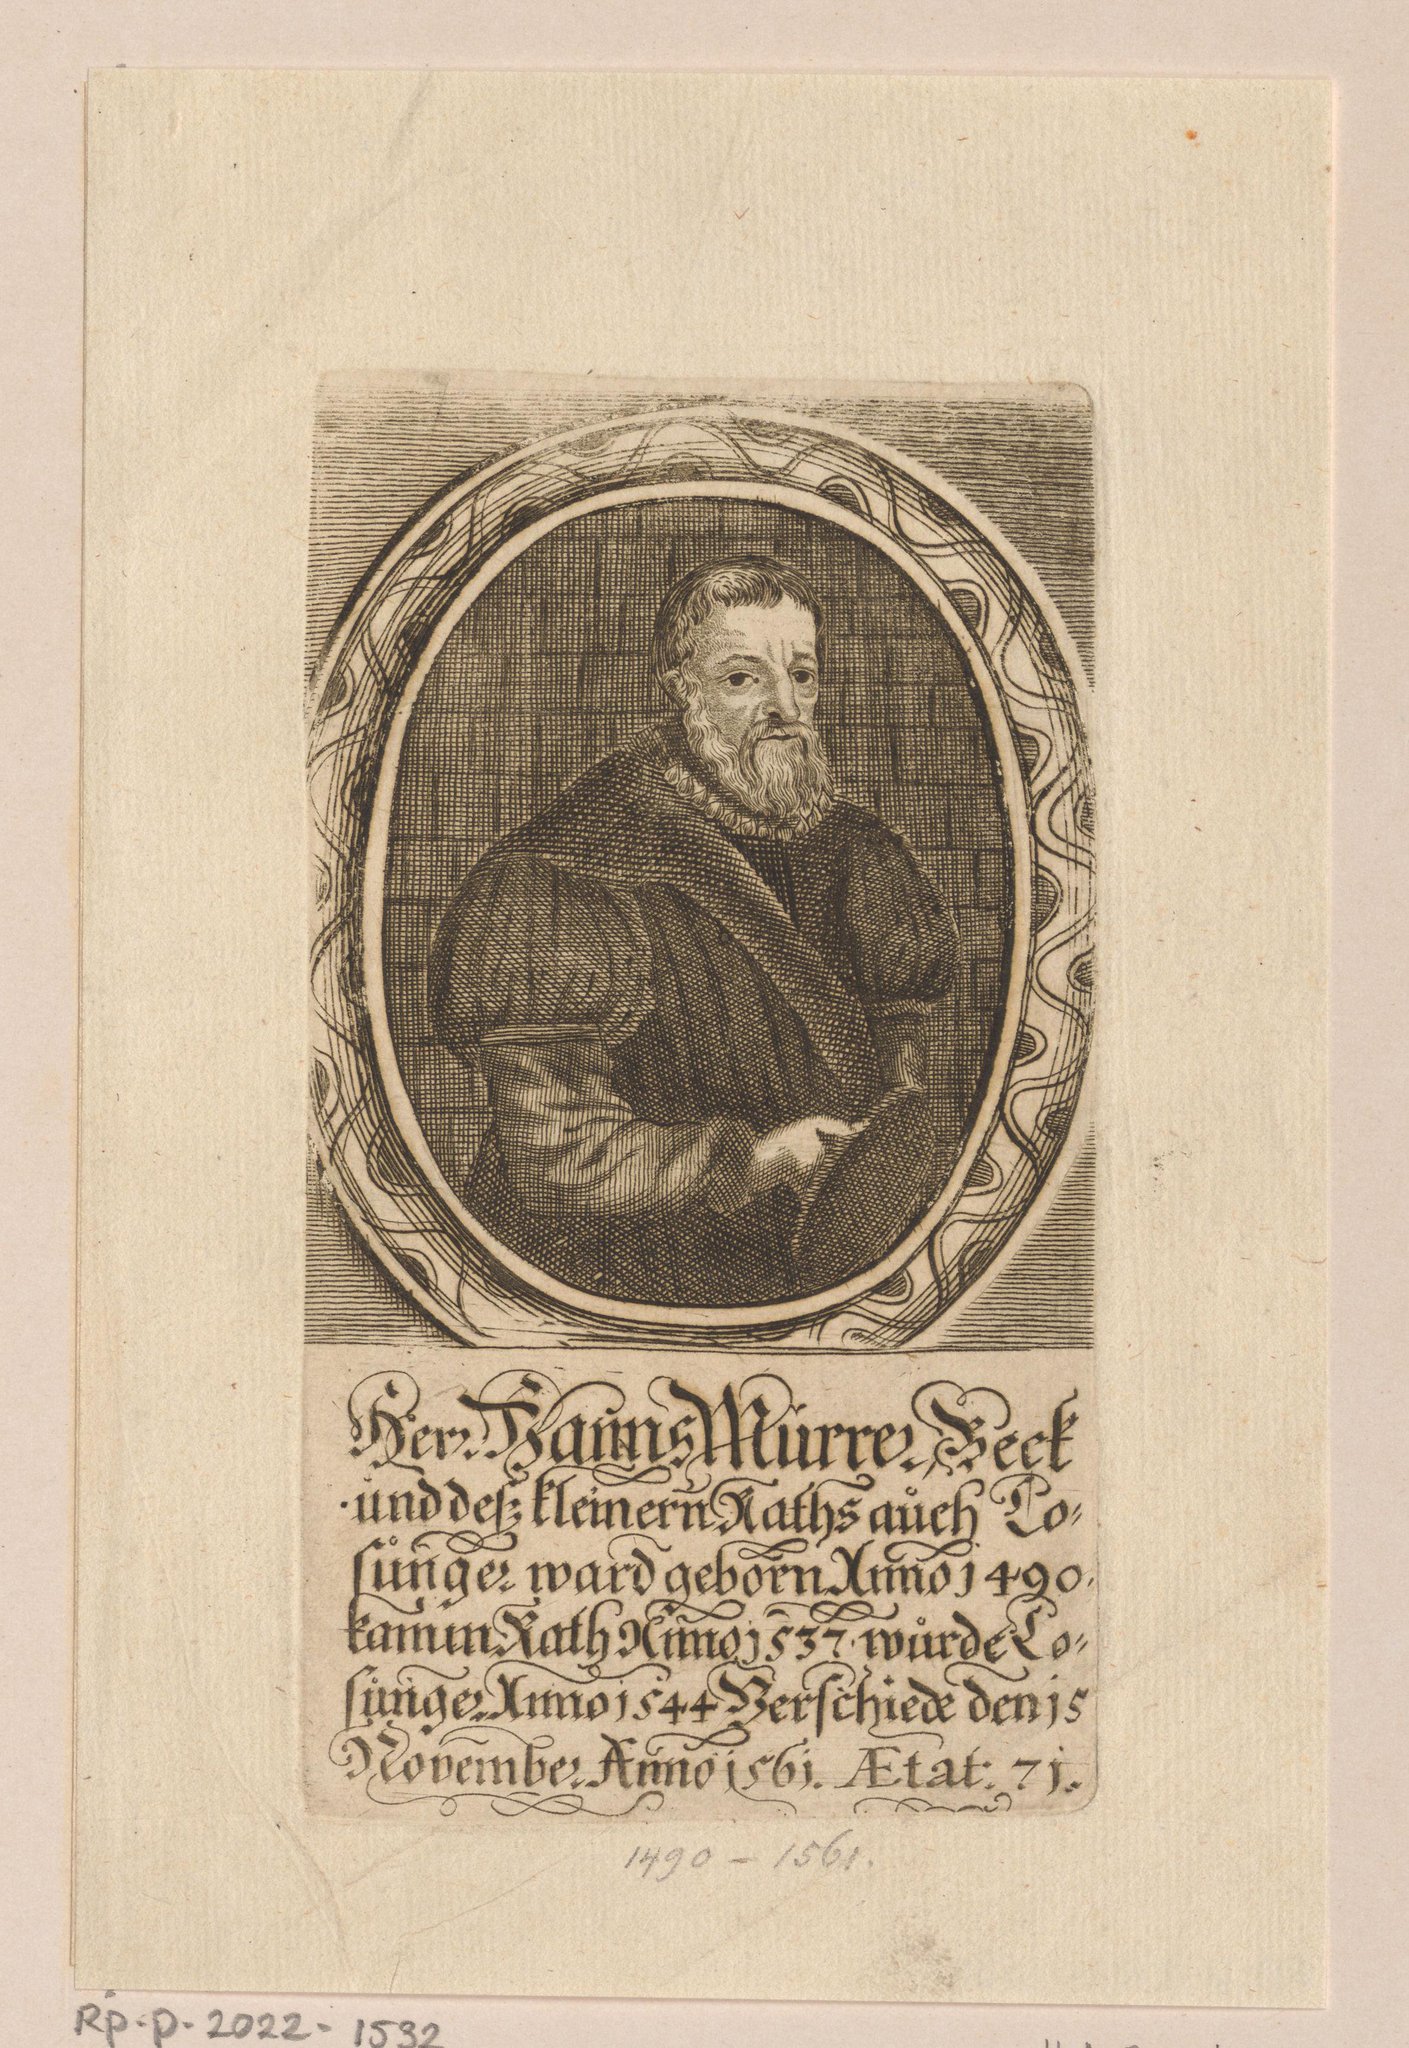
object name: print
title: Hanns Mürrer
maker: Anonymous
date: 1561-1650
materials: paper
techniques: engraving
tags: mayor, mayor, burgomaster, historical persons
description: Met zesregelig onderschrift in het Duits.